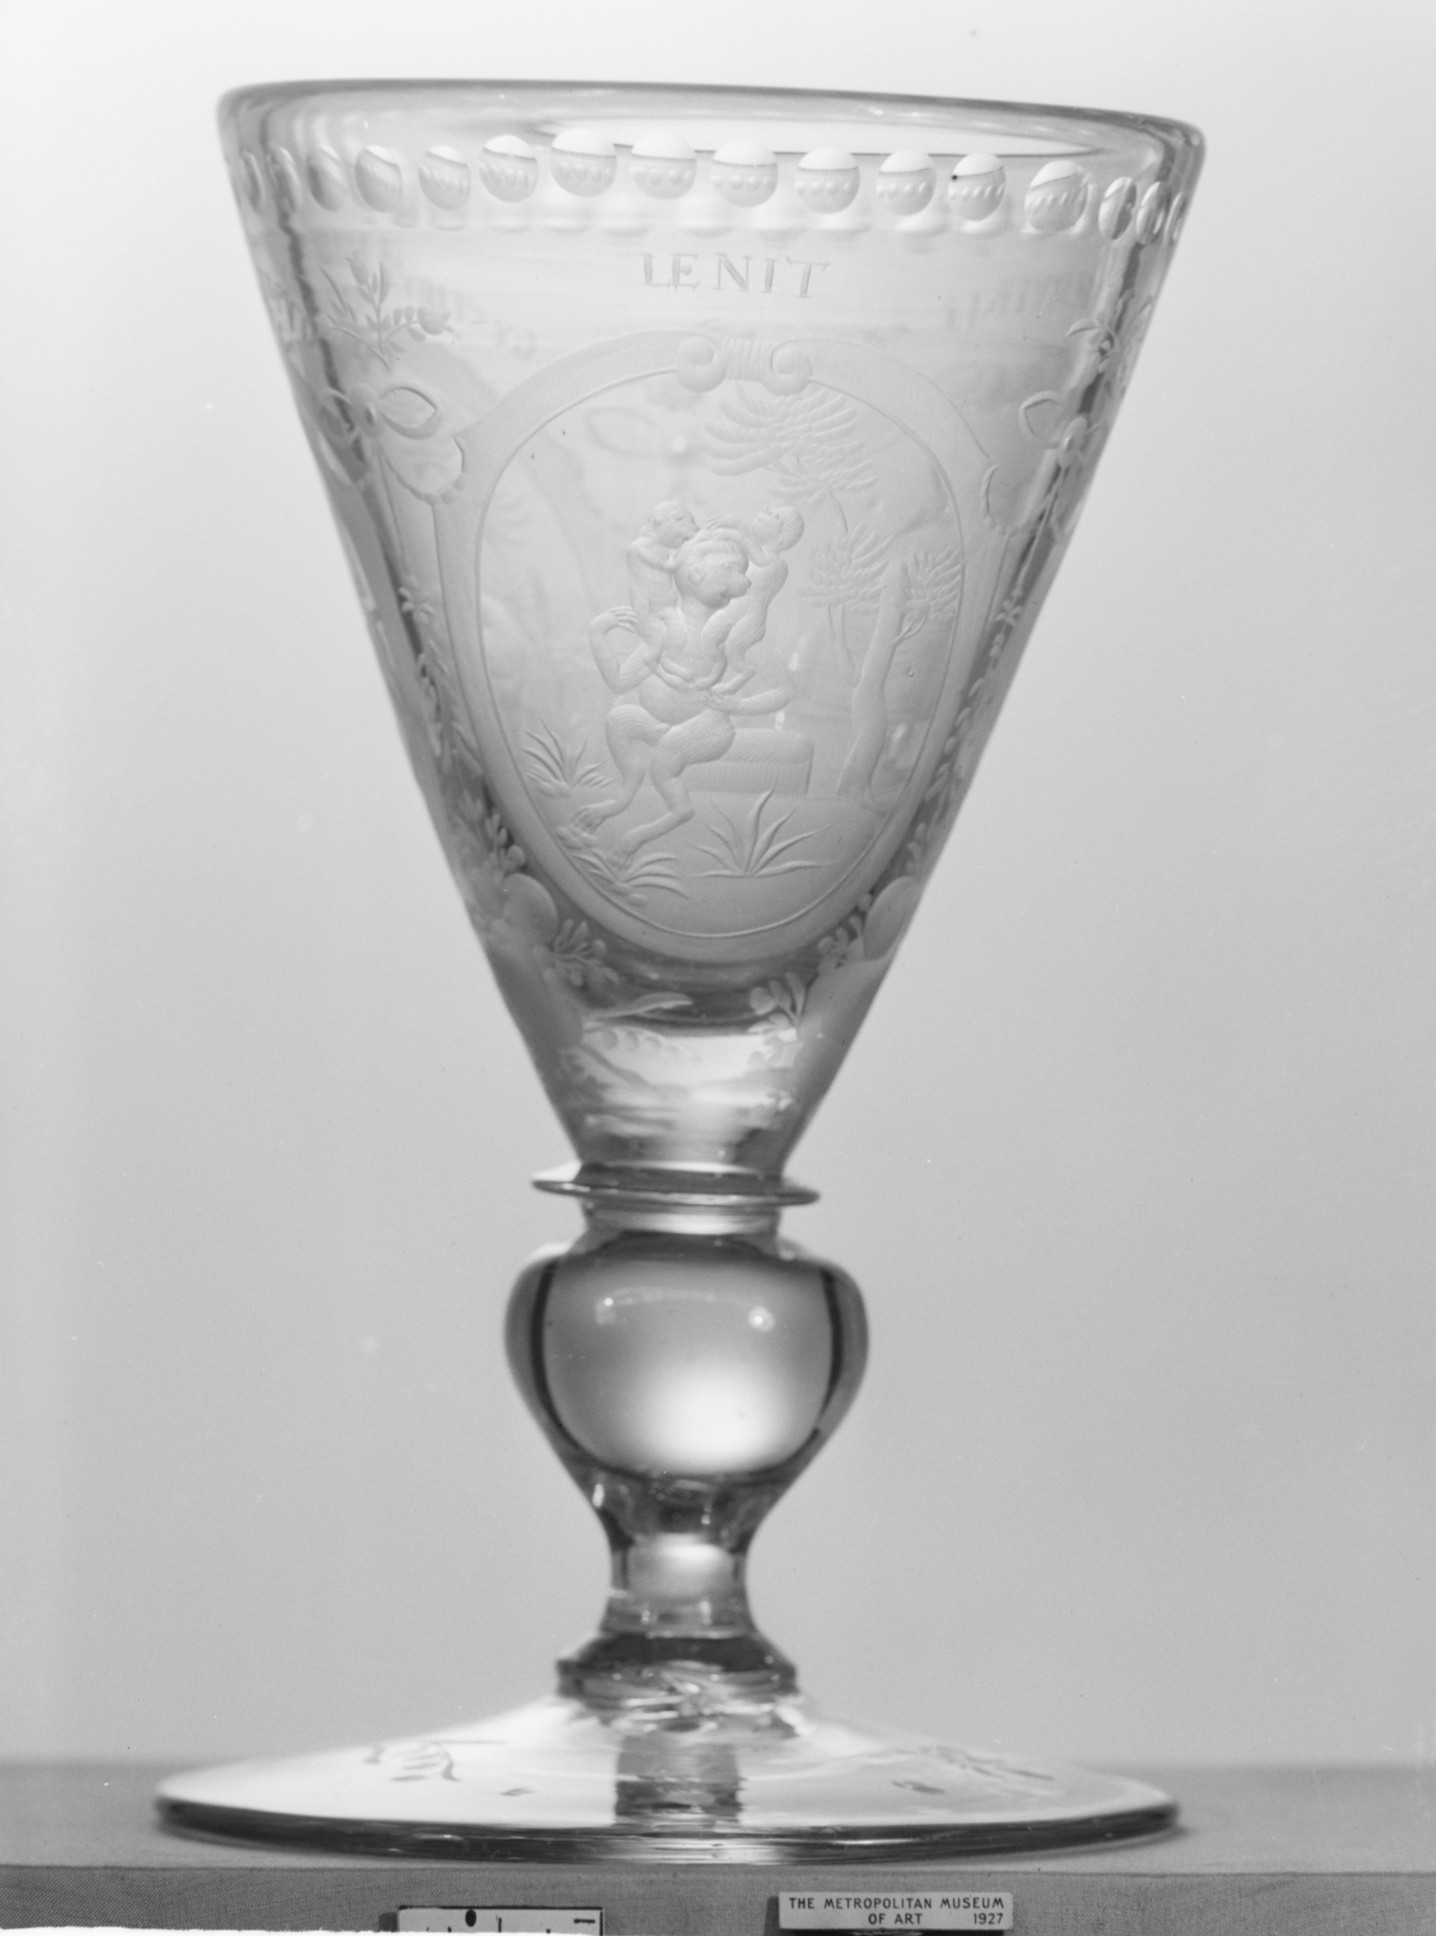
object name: wineglass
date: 1667-1700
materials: glass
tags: male nudes,trees